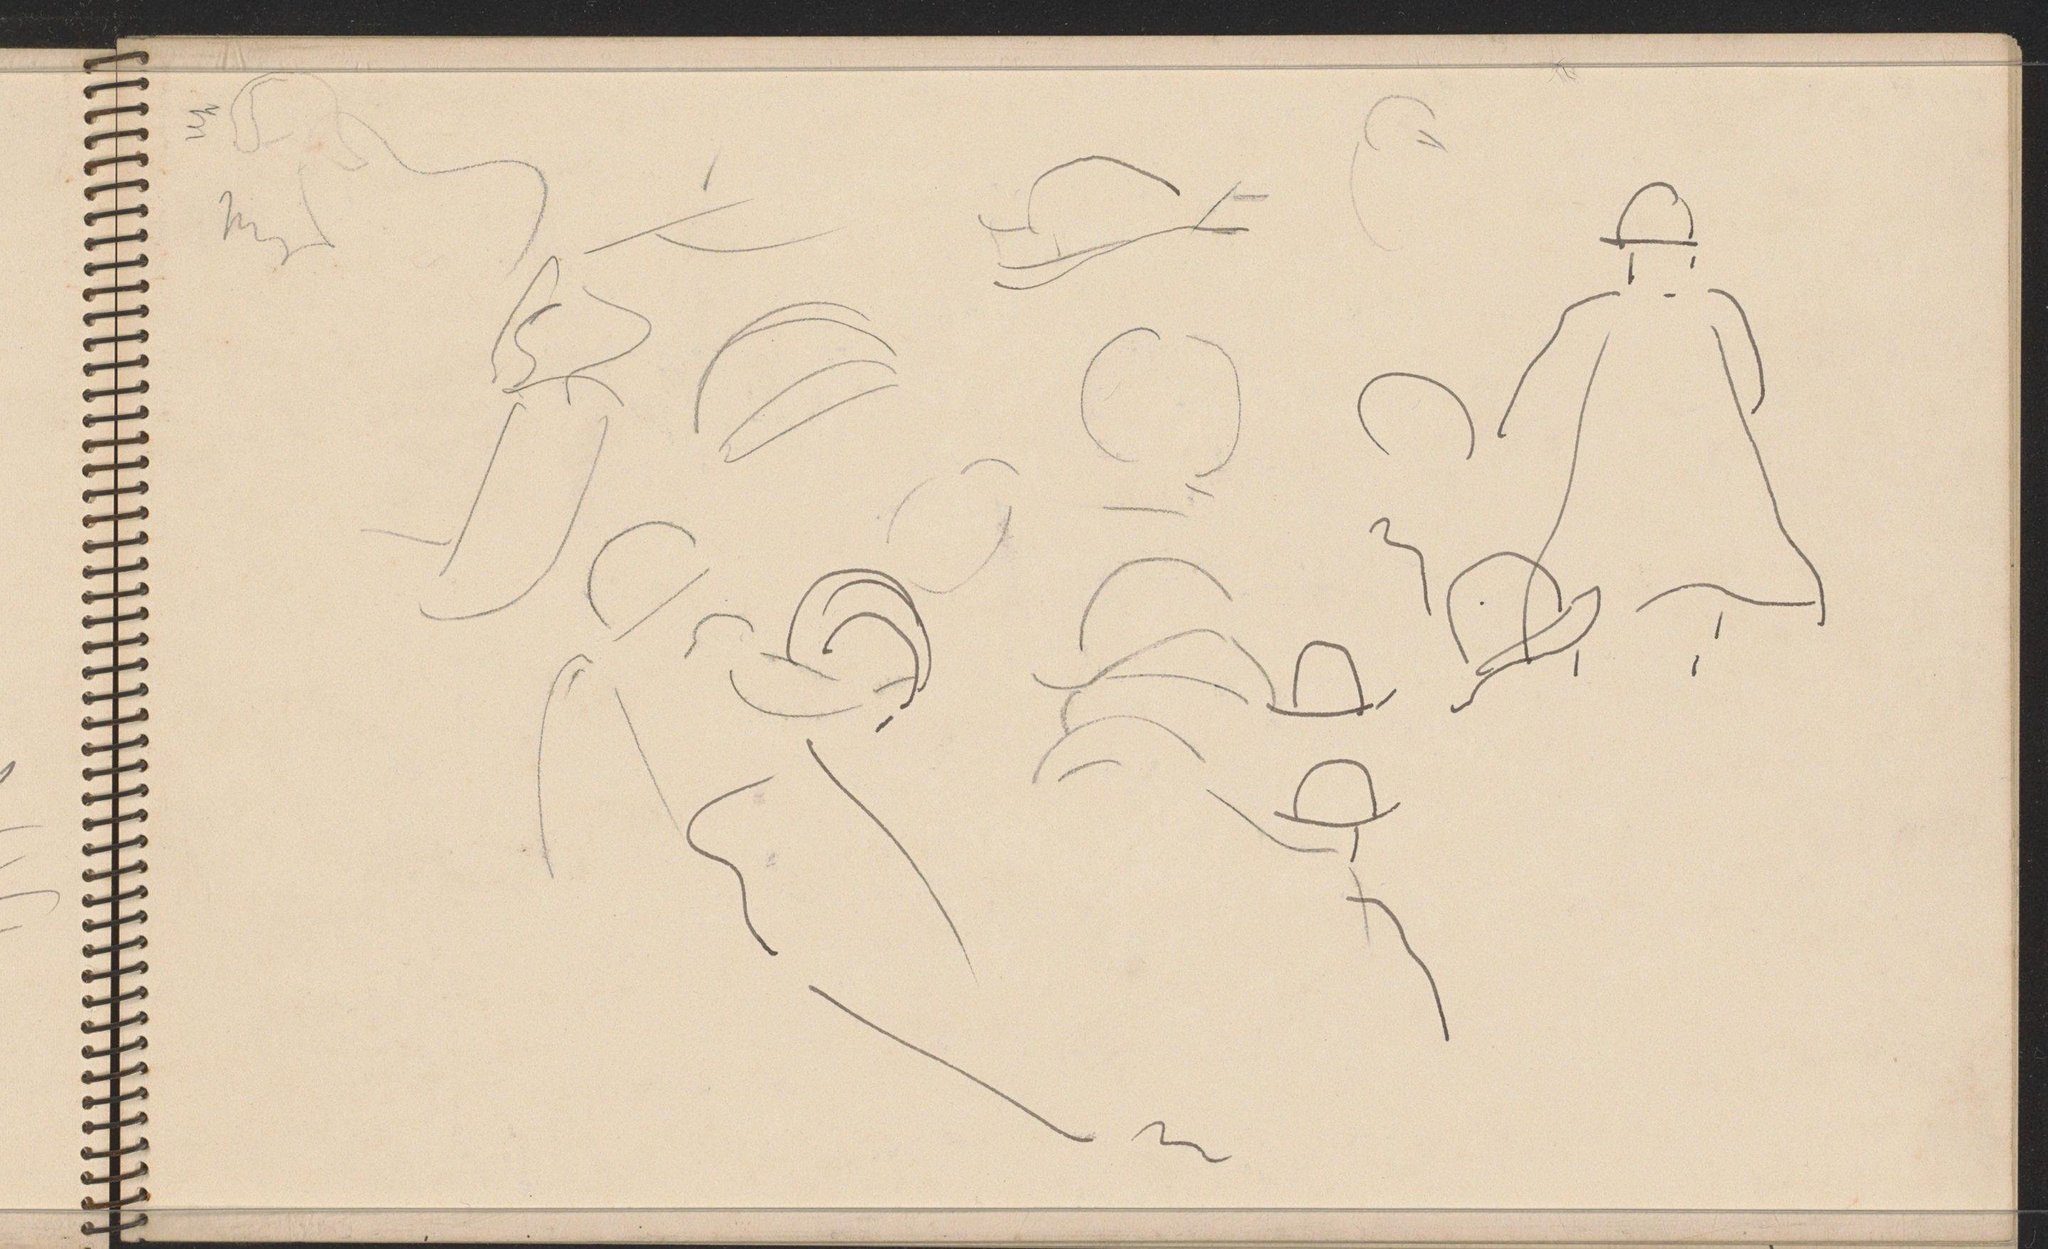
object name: sketchbook leaf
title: Hoeden en twee figuren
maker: carel adolph lion cachet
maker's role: draughtsman, print maker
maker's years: 1864-1945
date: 1930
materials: ink, paper, pencil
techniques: pen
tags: head-gear: hat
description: Blad 9 recto uit een schetsboek met 14 bladen.